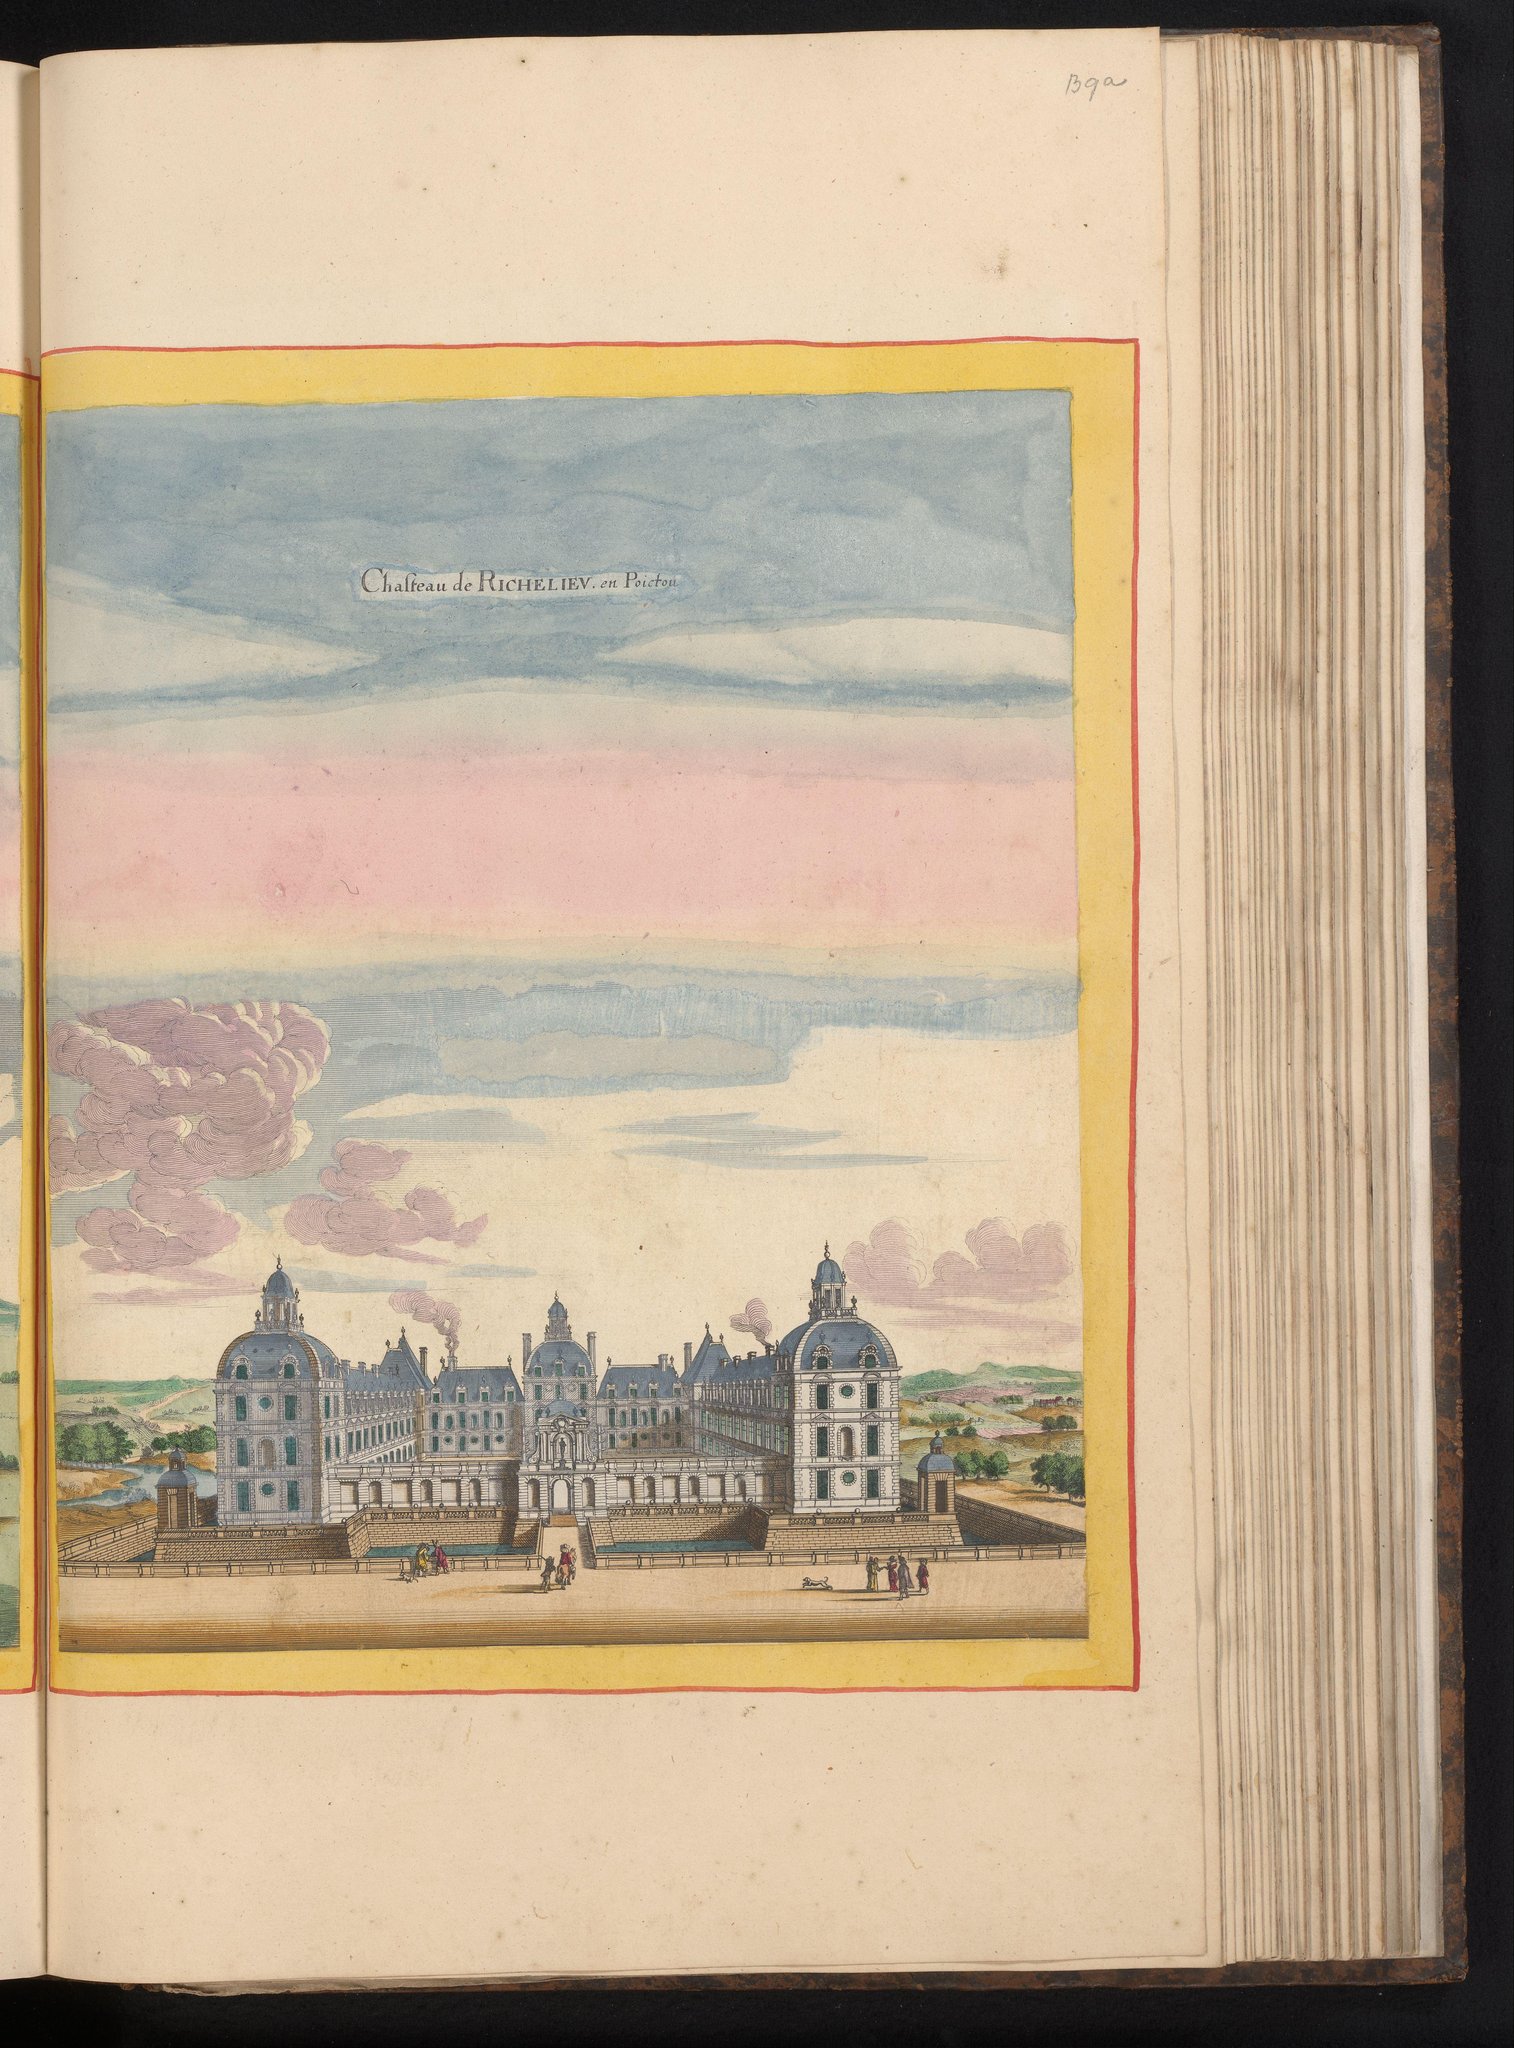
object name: album leaf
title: Chasteau de Richelieu, en Poictou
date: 1657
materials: paper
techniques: engraving, hand coloring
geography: frankfurt am main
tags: castle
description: Prent uit: Zeiller, Martin. Topographia Galliae. 13 dln. Frankfurt: Caspar Merian, 1657, dl. 7, na p. 58. De titel is uit de originele prent gesneden. Boven de gravure is een deel lucht en wolken (bij)geschilderd, waarin de titel gelijmd is.